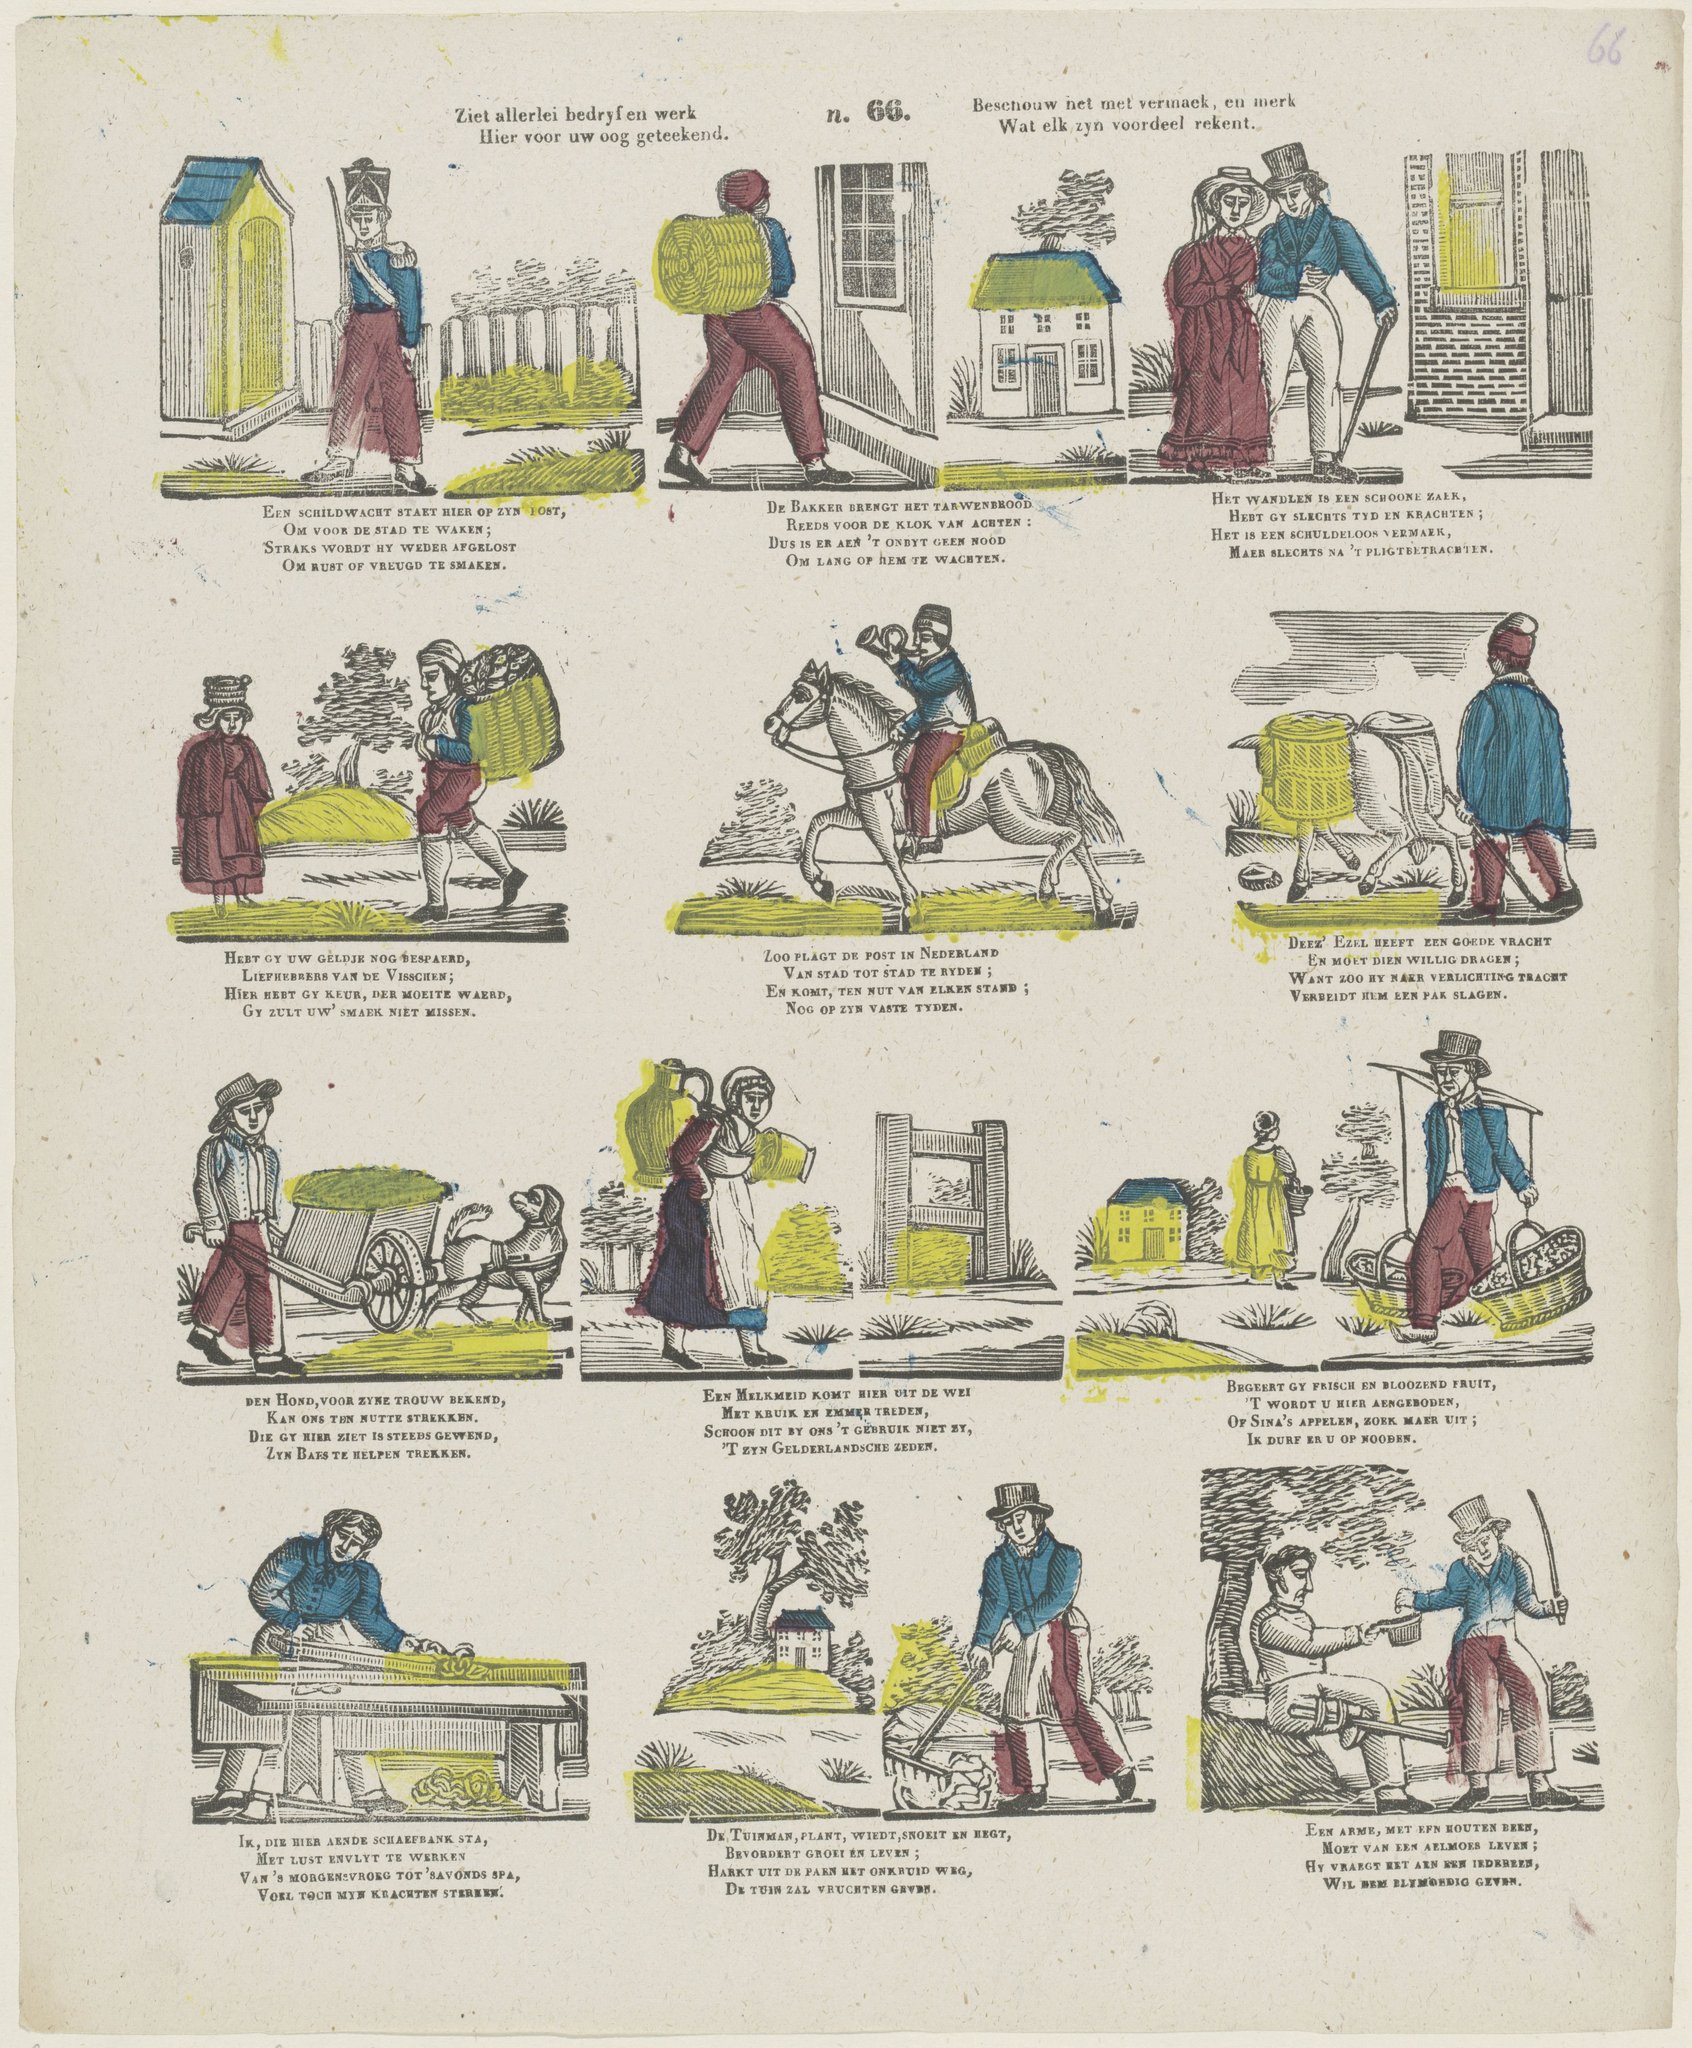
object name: popular print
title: Ziet allerlei bedryf en werk / hier voor uw oog geteekend / Beschouw het met vermaek, en met / Wat elk zyn voordeel rekent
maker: Anonymous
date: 1833-1900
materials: paper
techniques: colour, letterpress printing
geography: netherlands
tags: craft-production, skilled handiwork, farmers, characters (human types), street-trader, crafts and industries, merchant, salesman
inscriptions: collector's mark: Lugt 2760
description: Blad met 12 voorstellingen van figuren en ambachtslieden, zoals een schildwacht, een melkmeid en een tuinman. Onder elke afbeelding een vierregelig vers. Genummerd midden boven: n. 66.